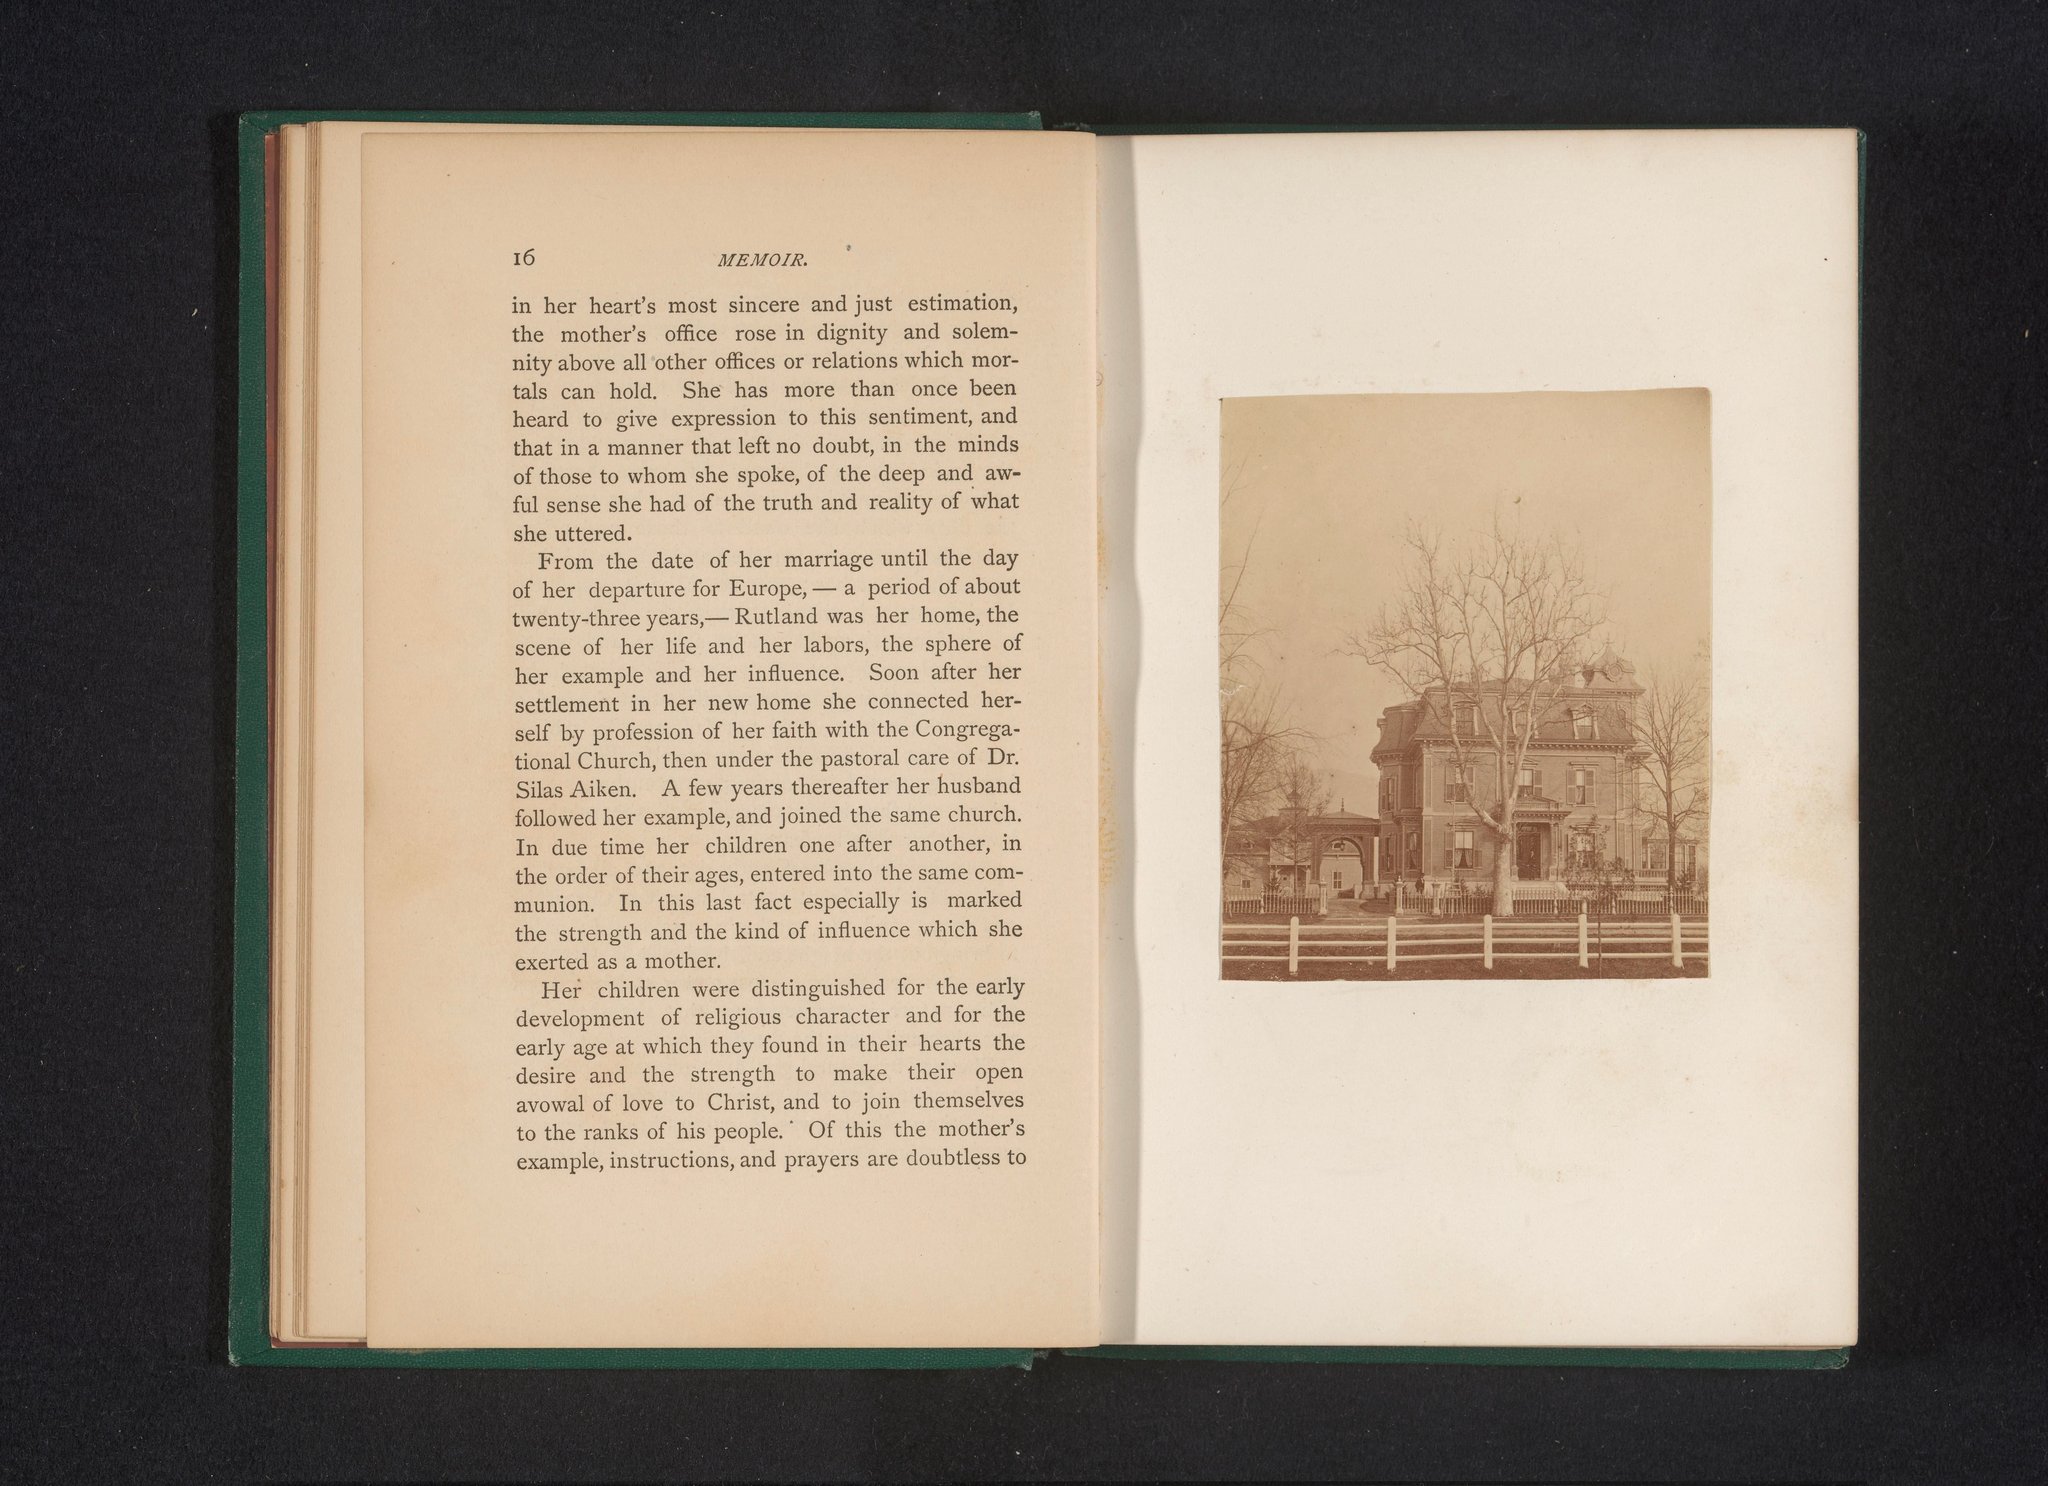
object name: page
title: Exterieur van een landhuis te Rutland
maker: Anonymous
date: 1868-1873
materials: photographic support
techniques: albumen print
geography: rutland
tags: rural housing, e.g. country-house, villa, cottage, façade (of house or building)